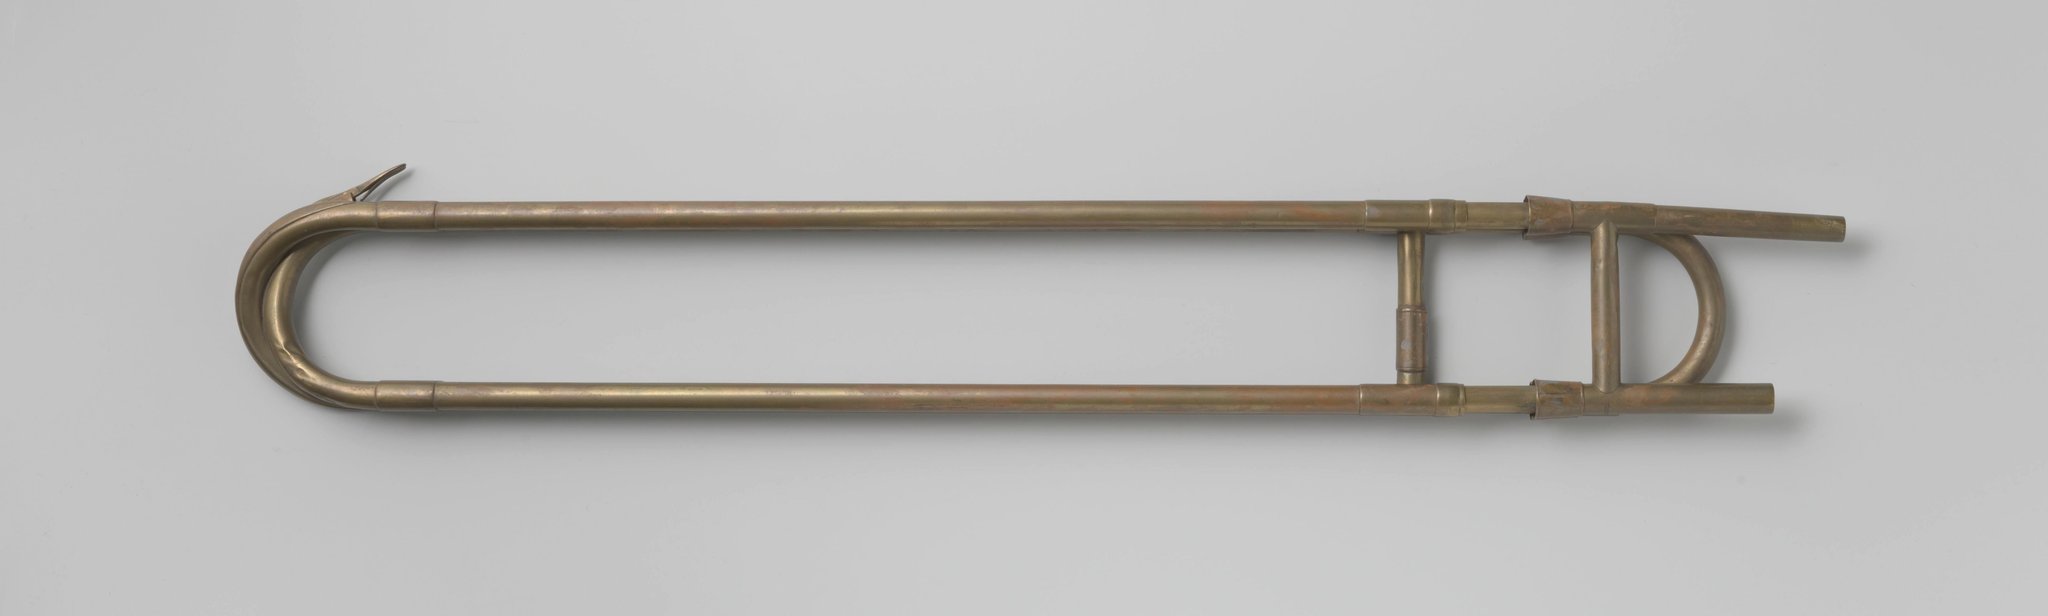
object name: wind instrument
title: Trombone (fragment)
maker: Anonymous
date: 1830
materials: copper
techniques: casting, cutting, woodworking, snipping, soldering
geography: netherlands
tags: j. verkruisse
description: Het buisgedeelte en schuif van een bastrombone van J. Verkruisse in 1830/32 bij het Regiment Kurassiers No. 9.